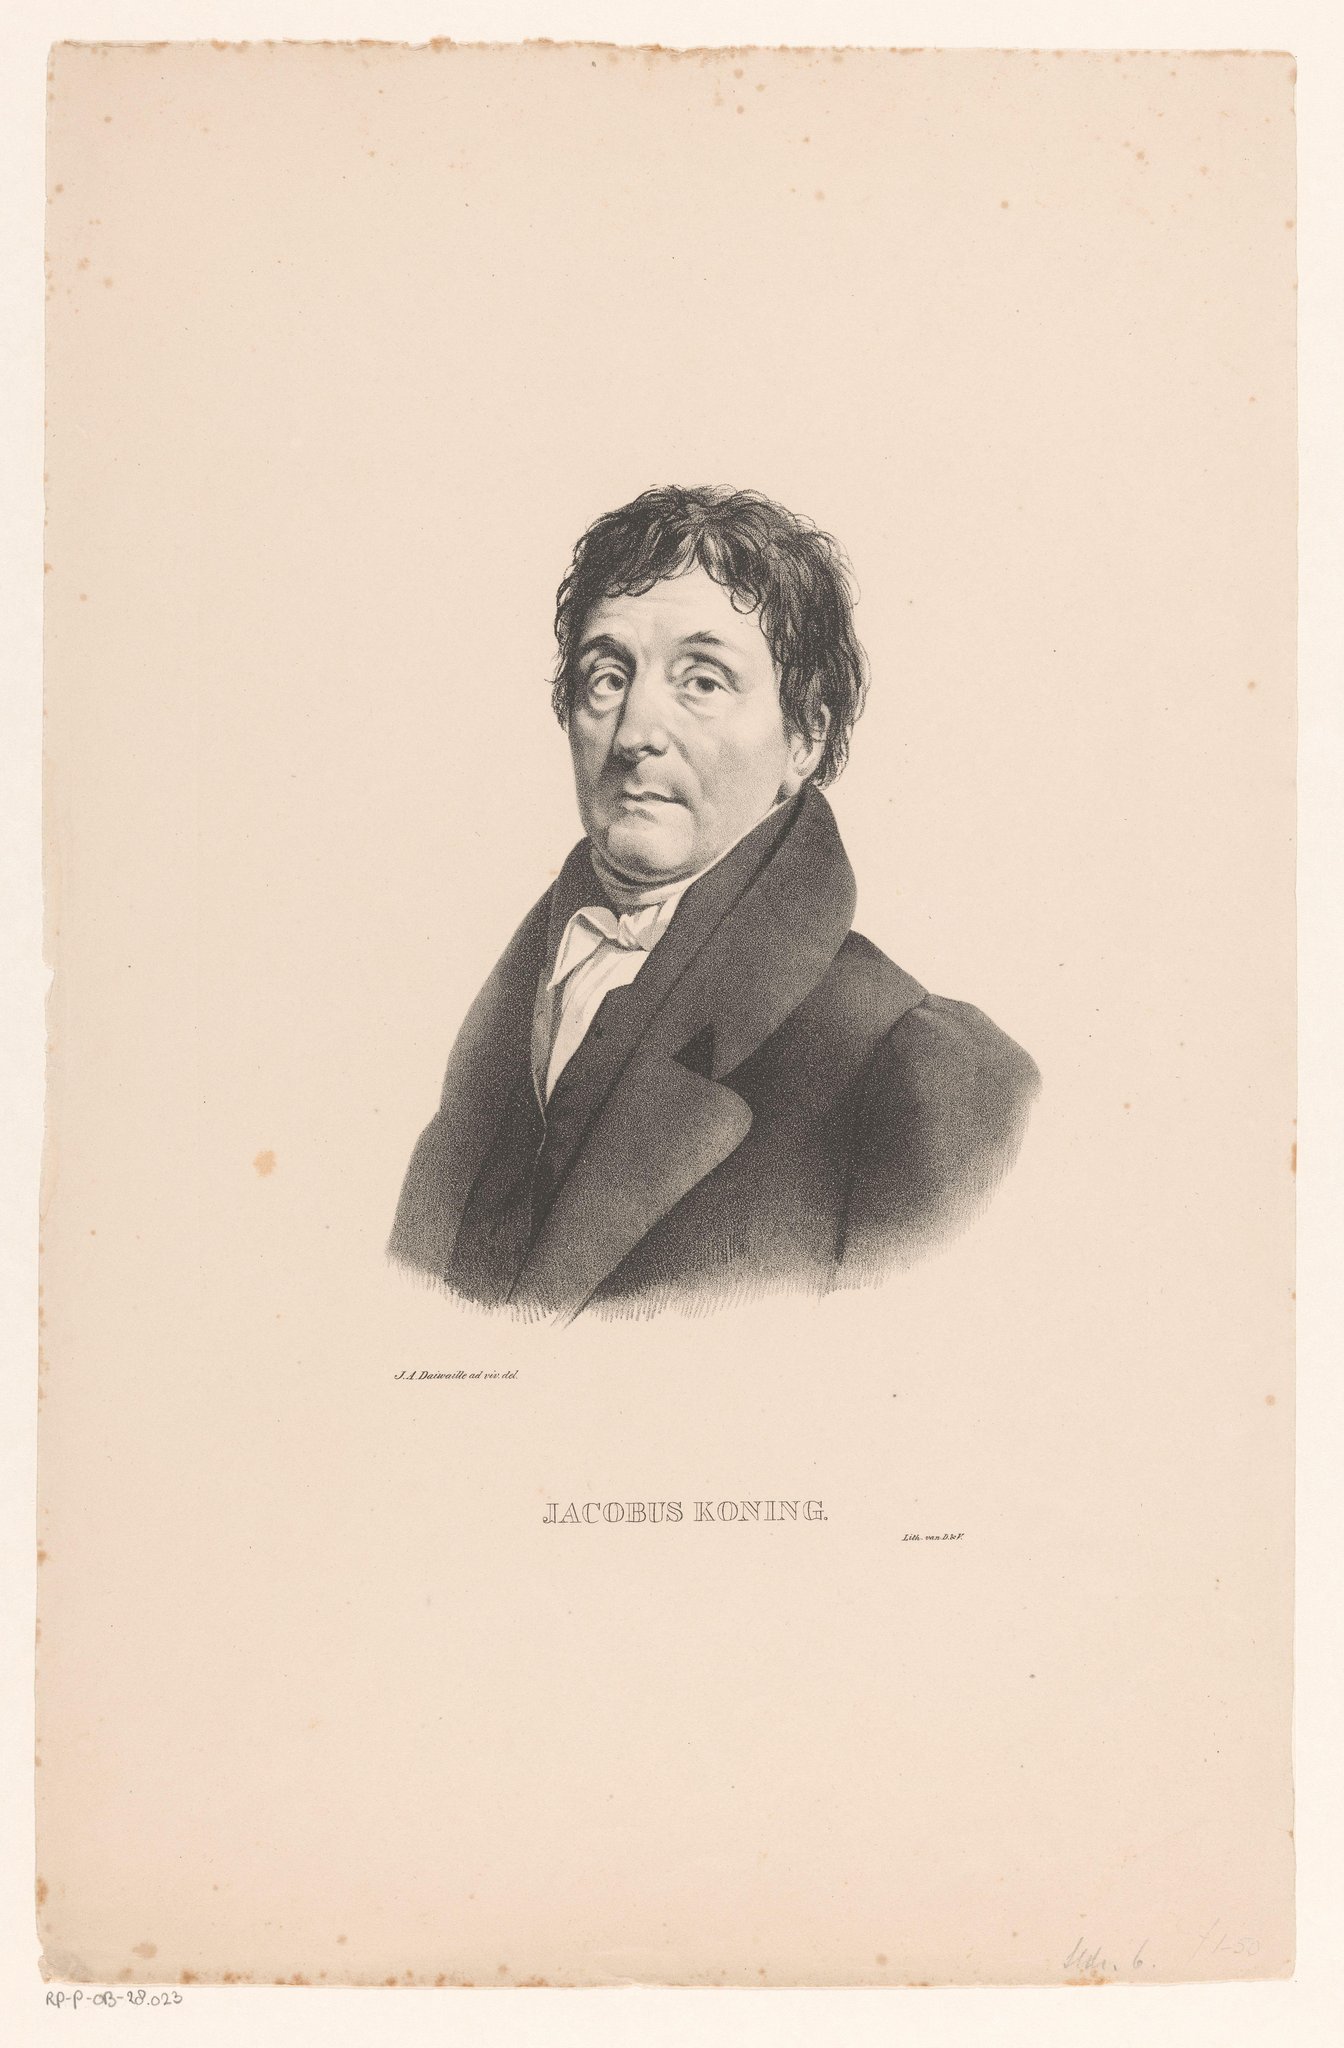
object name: print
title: Portret van Jacobus Koning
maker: jean augustin daiwaille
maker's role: draughtsman, print maker, printer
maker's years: 1786-1850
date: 1809-1850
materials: paper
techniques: lithograph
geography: amsterdam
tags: historical persons (+ head (and shoulders) (portrait))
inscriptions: collector's mark: Lugt 2228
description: De geportretteerde draagt een donkere jas en een witte gestrikte das. Onder het portret zijn naam.